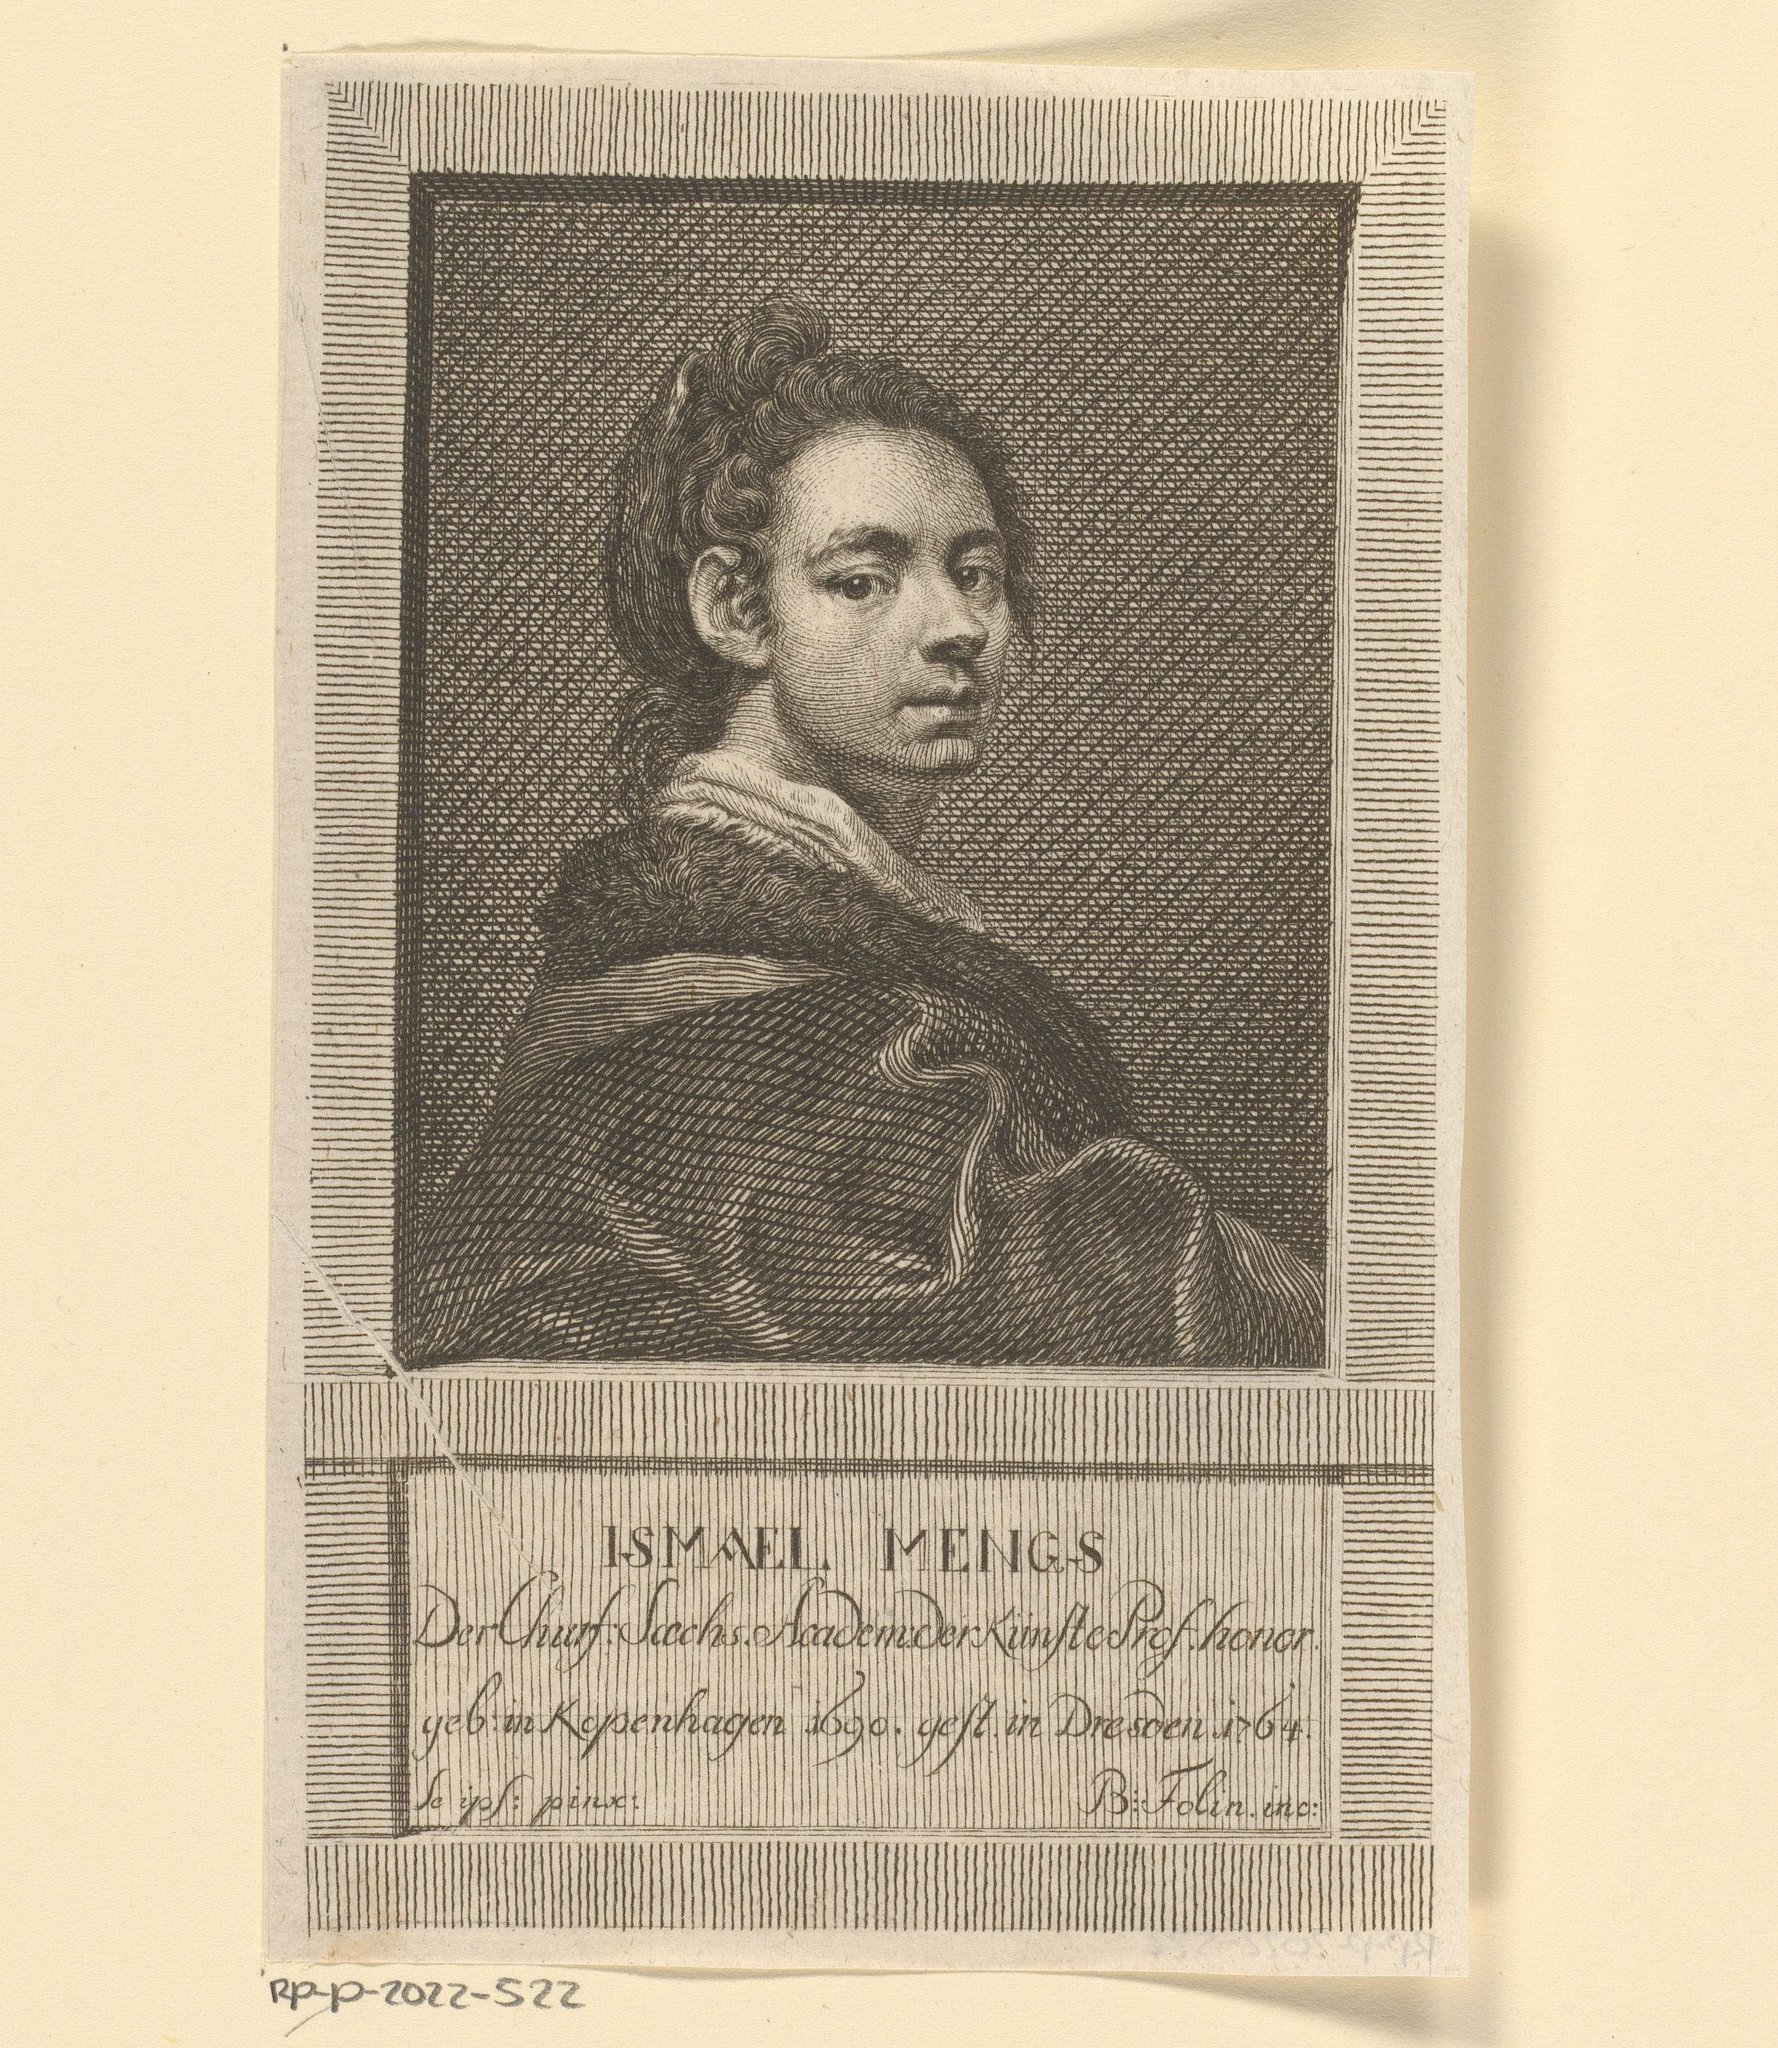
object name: print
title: Portret van Ismael Mengs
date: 1740-1808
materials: paper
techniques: engraving, etching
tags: copenhagen (city), painter, ismael mengs, historical persons, portrait, self-portrait of artist